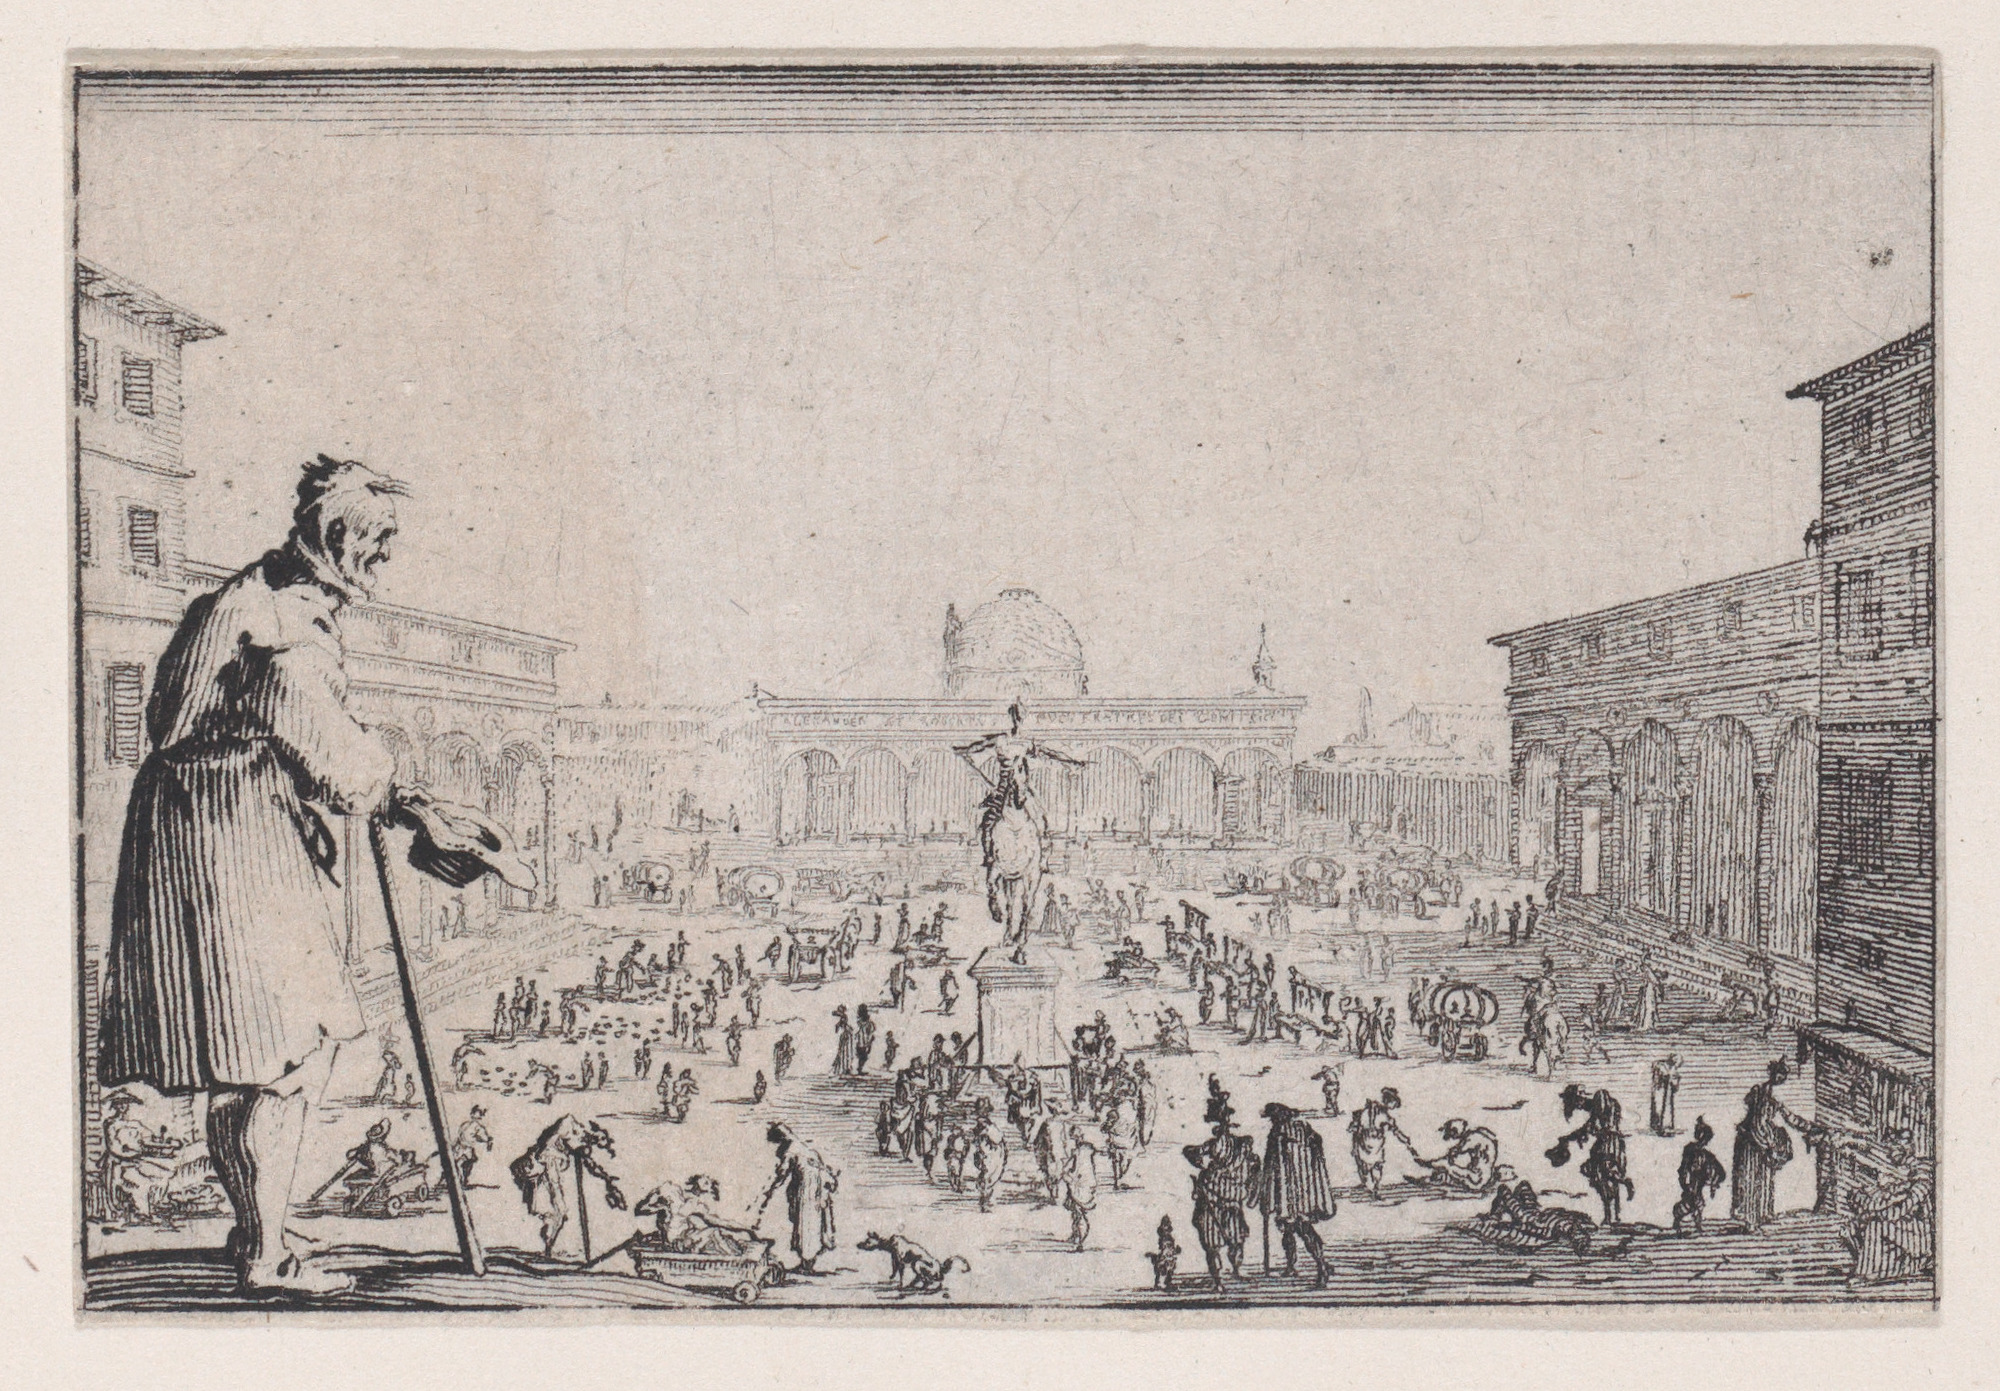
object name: print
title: Le Marché de la Place de L'Annonciade a Florence (The Marketplace of L' Annunziata in Florence), from "Les Caprices" Series A, The Florence Set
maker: jacques callot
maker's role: artist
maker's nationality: french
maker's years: 1592-1635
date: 1617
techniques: etching